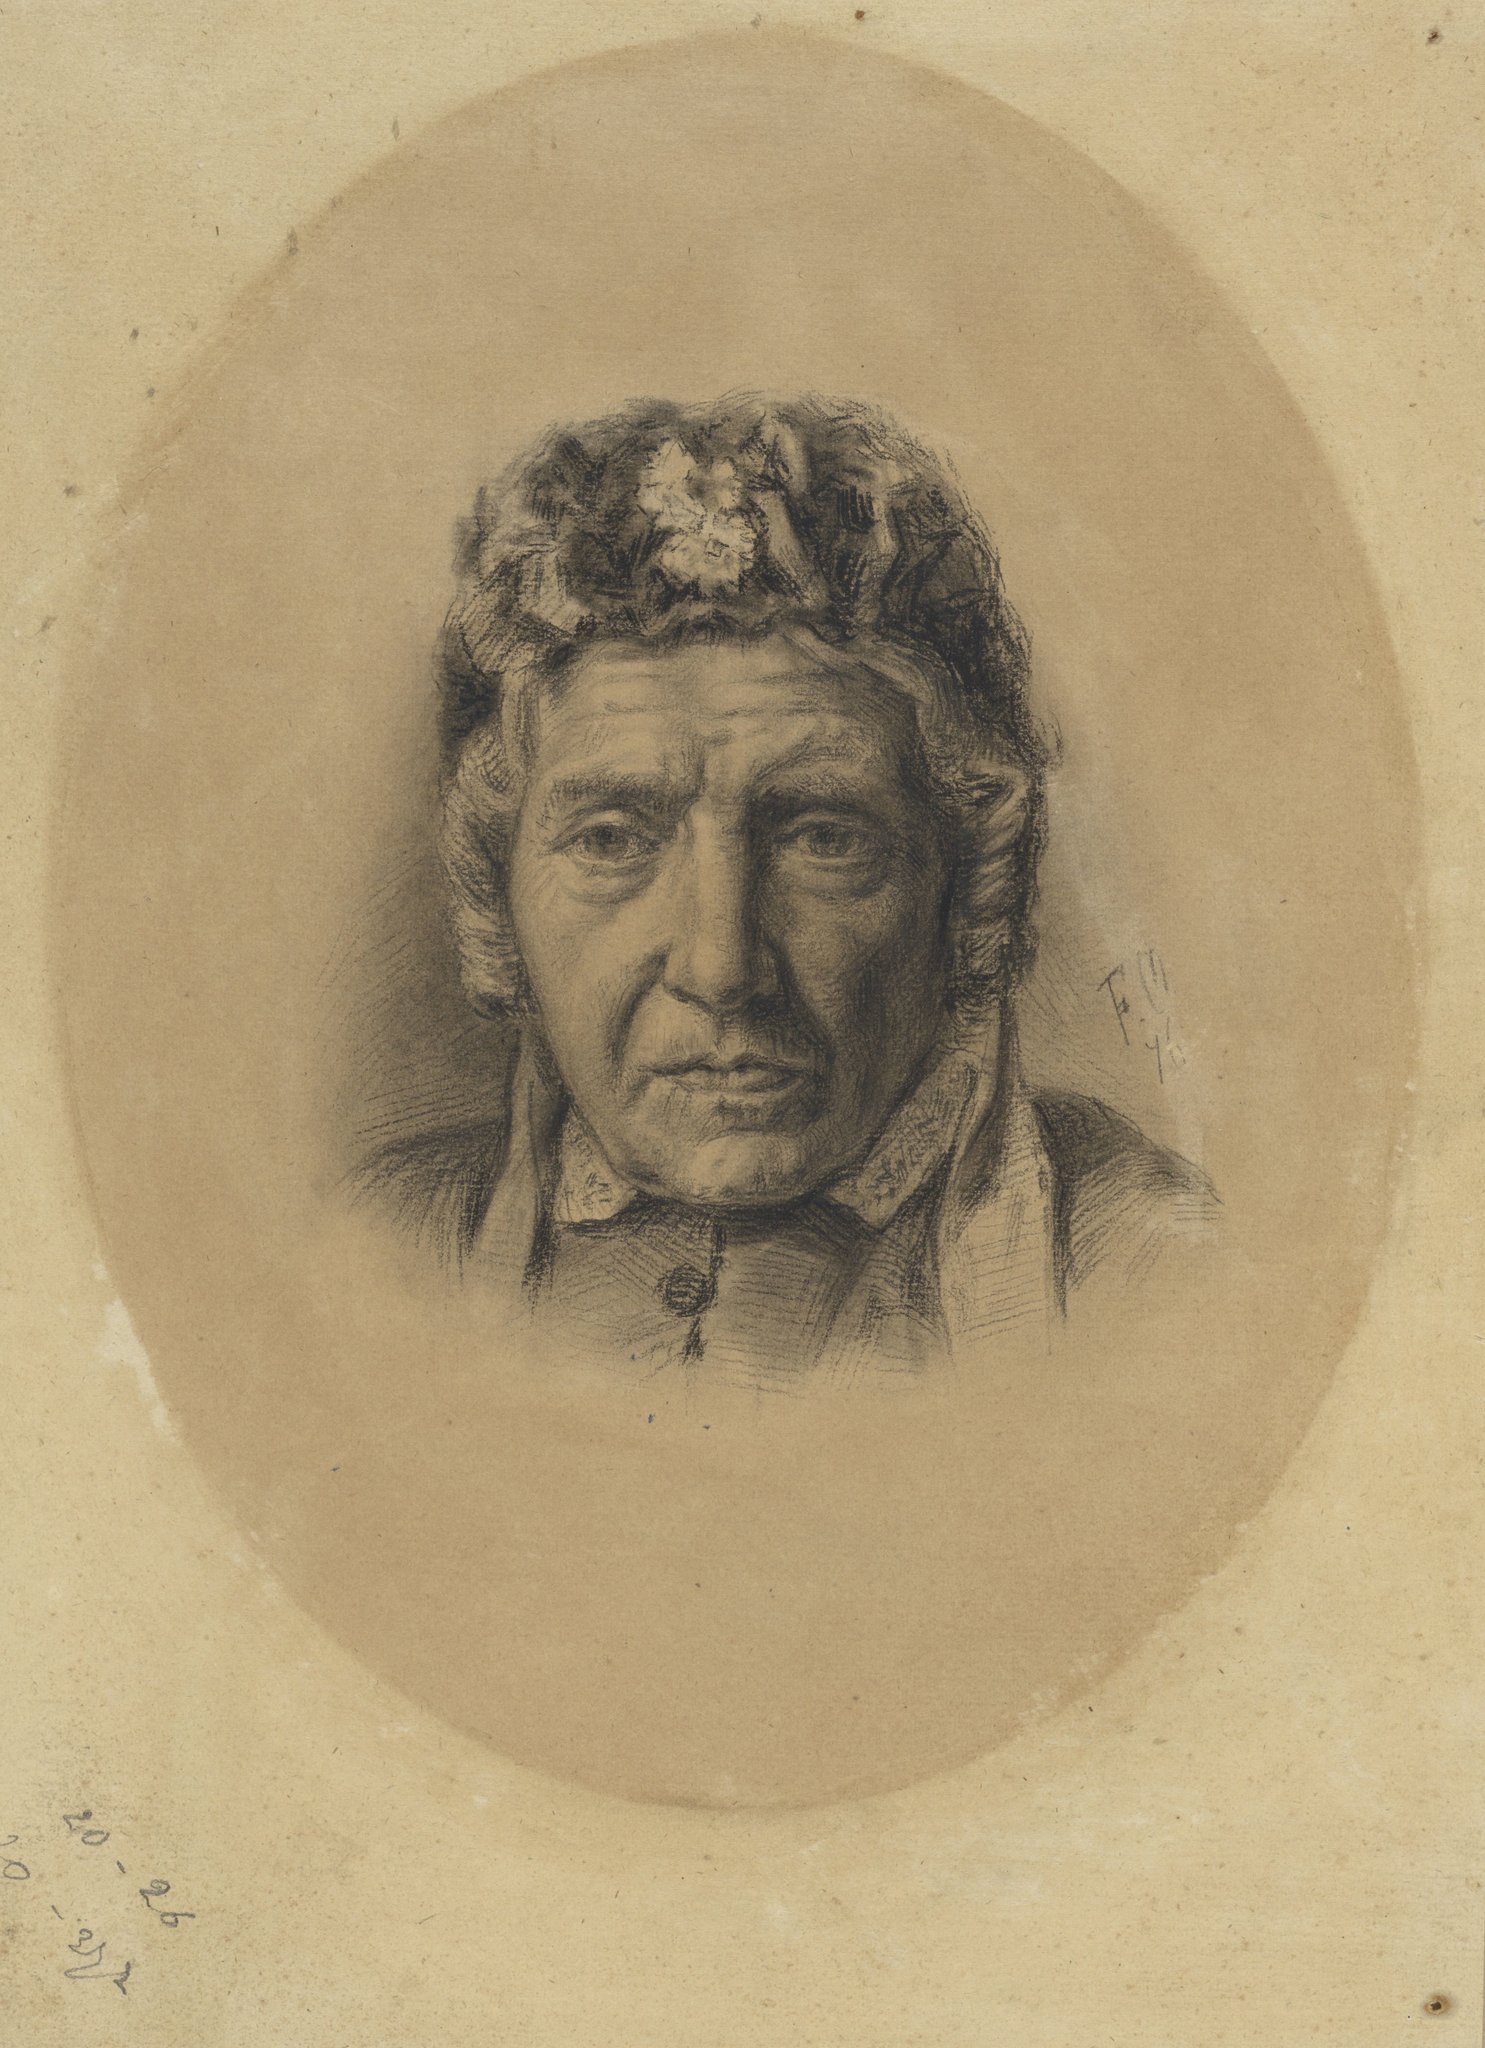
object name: drawing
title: Portret van J.M. Vogelsang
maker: ferdinand oldewelt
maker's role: draughtsman, print maker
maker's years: 1857-1935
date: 1876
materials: chalk, paper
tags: historical persons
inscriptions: date